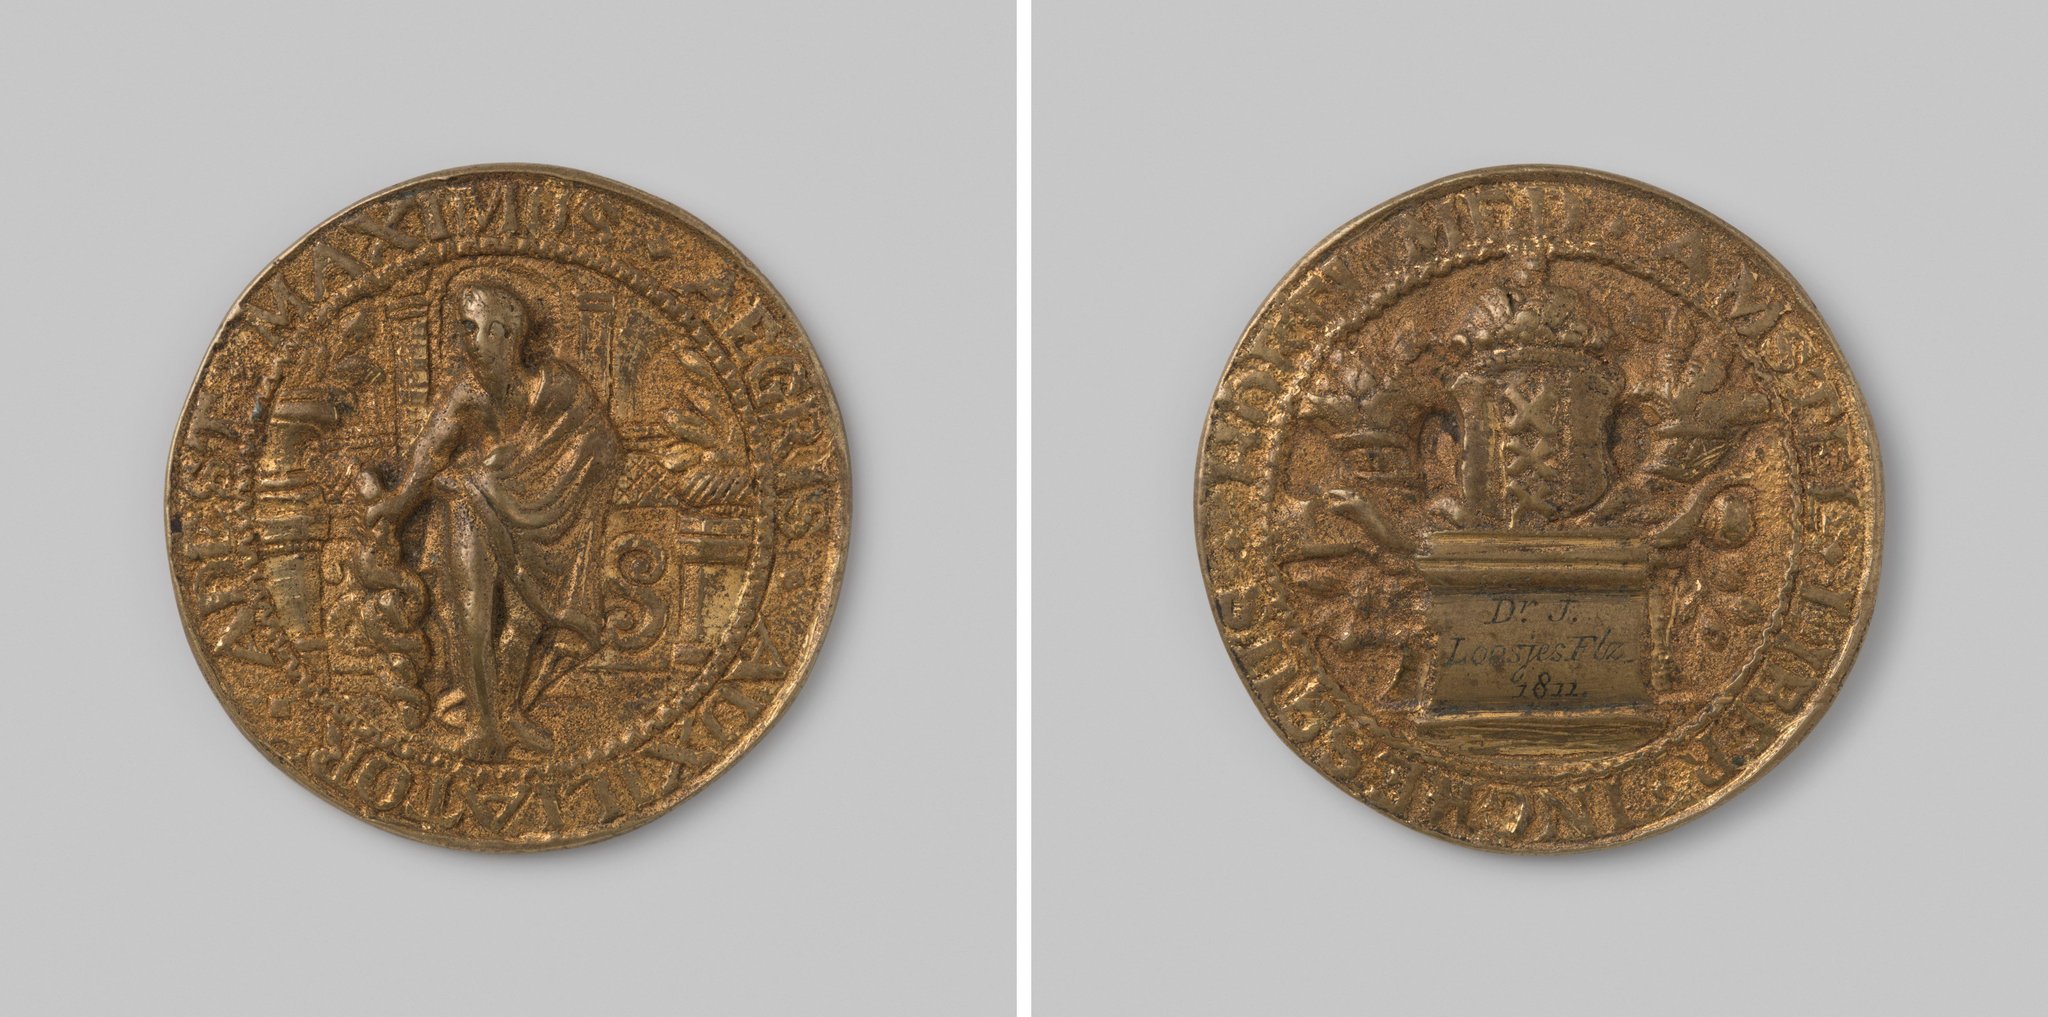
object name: history medal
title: Toegangspenning tot de Hortus Medicus te Amsterdam 1696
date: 1696-1699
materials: brass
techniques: casting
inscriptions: circumscription: ‘HORTI MED AMSTEL LIBER INGRESSUS’, inscription: ‘Dr.J. / Loosjes Flz. / 1811.’, circumscription: ‘MAXIMUS AEGRIS AUXILIATOR ADEST’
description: Gegoten messing penning met op de voorzijde Aesculapius en op de keerzijde een altaar waarop het gekroonde stadswapen, een caduceus en cornucopiae waaruit kruidentakken, op naam van Dr.J. Loosjes Flz. 1811